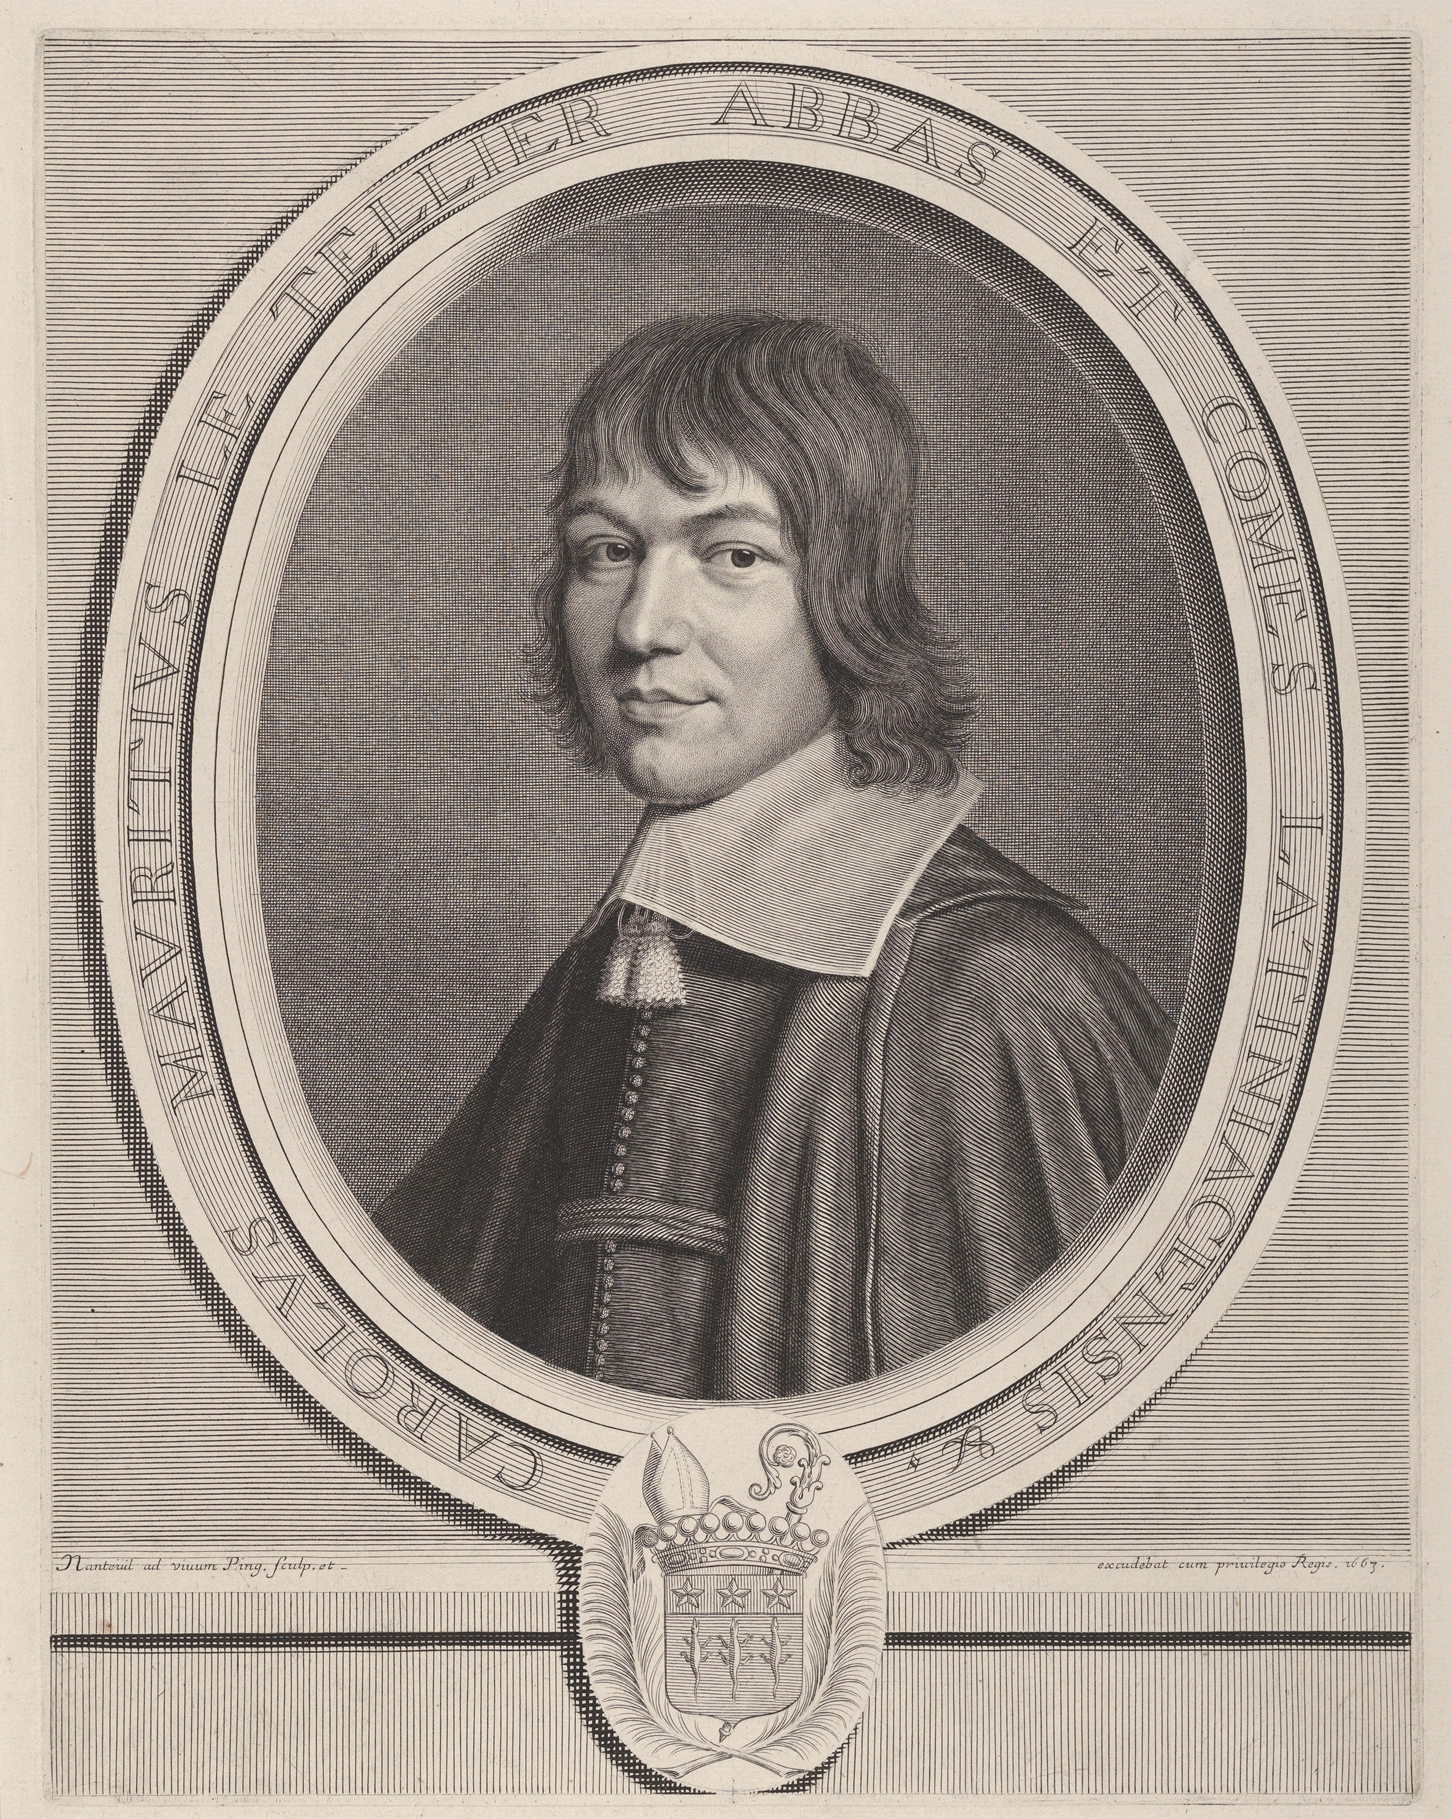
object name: print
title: Charles-Maurice Le Tellier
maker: robert nanteuil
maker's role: artist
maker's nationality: french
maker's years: 1623-1678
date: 1663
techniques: engraving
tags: men,portraits